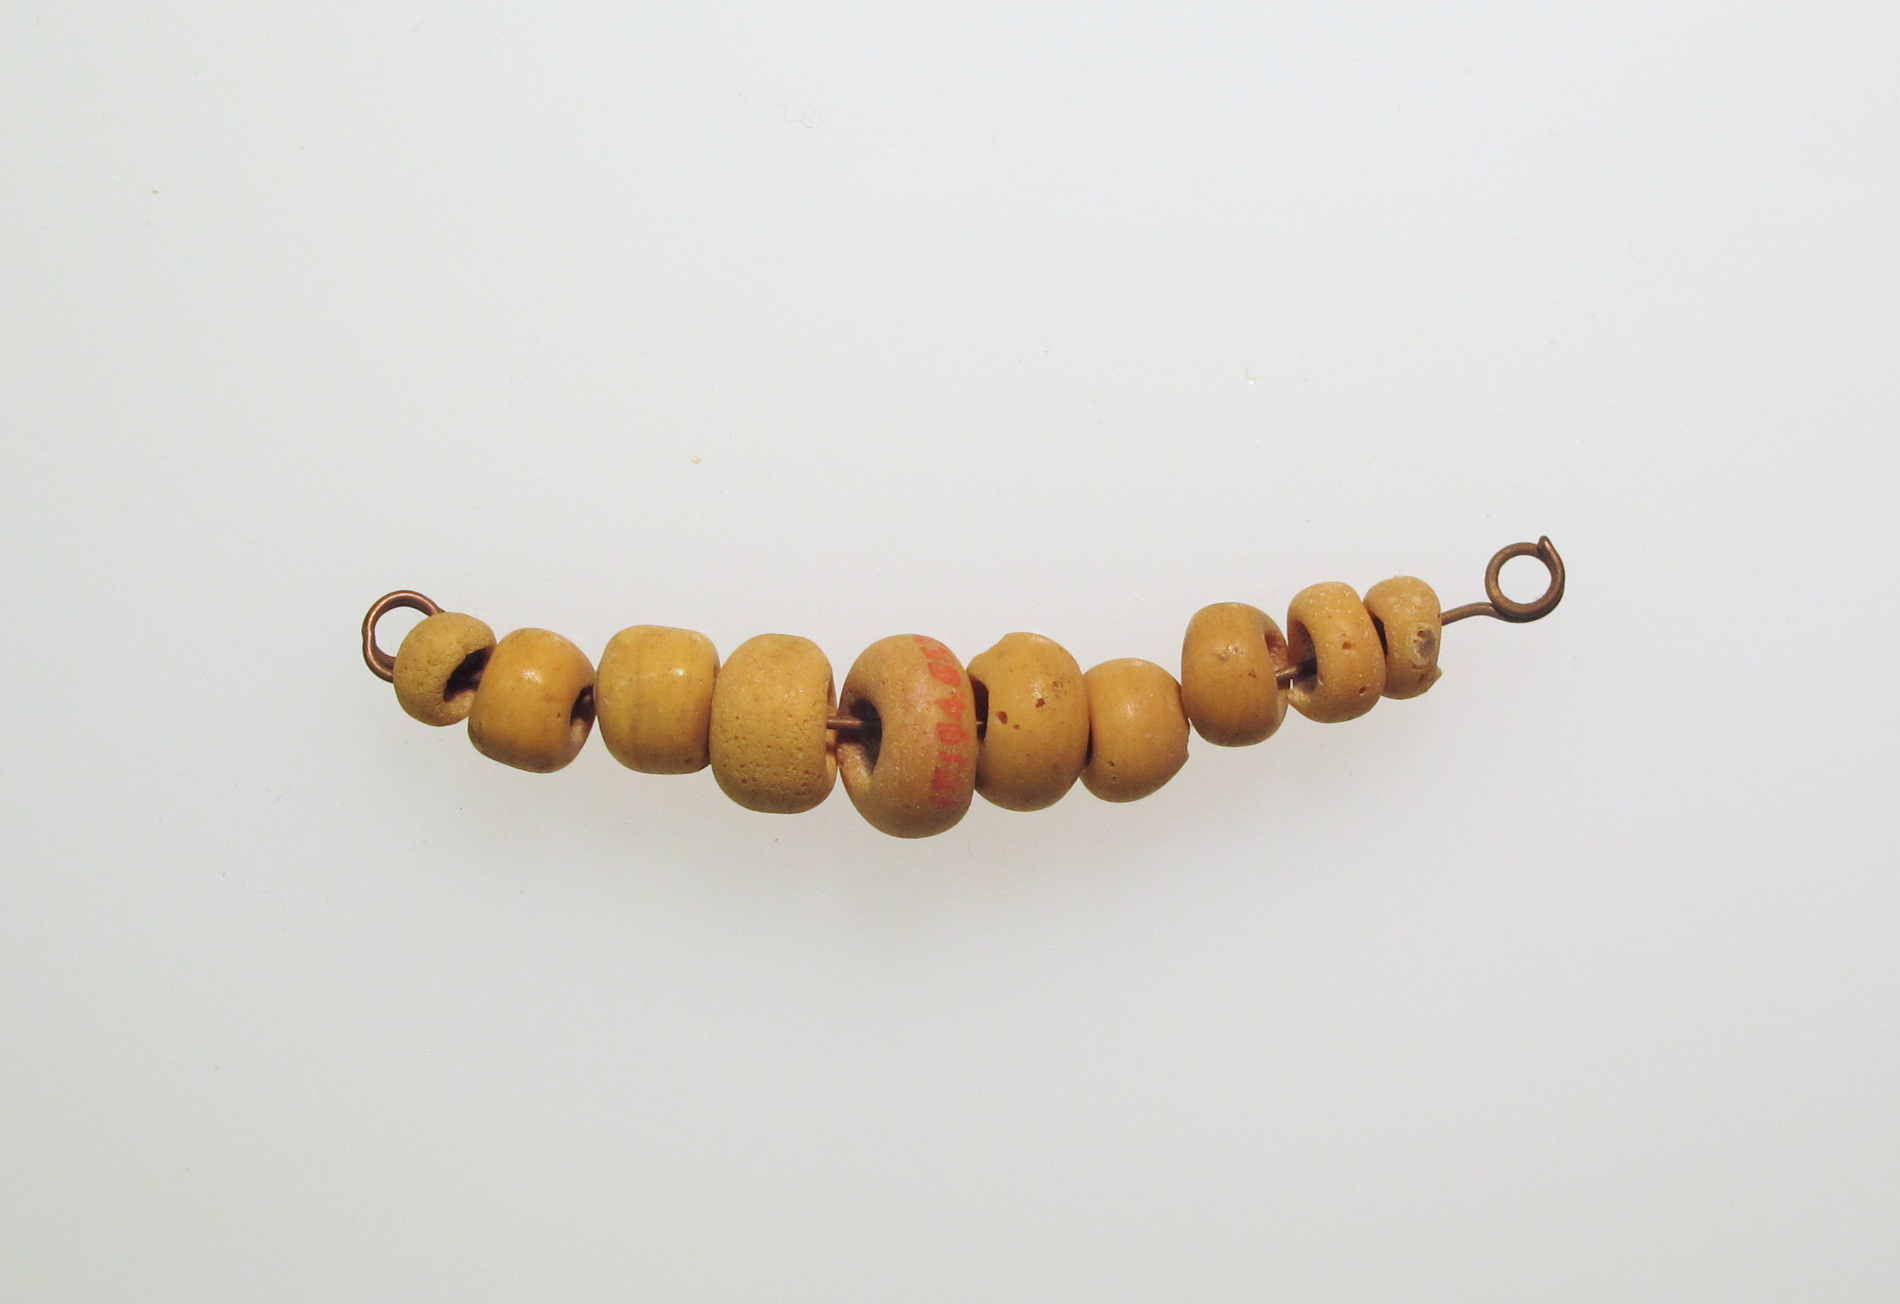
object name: bead, 10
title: Beads, 10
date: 7000 BCE-330 CE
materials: glass